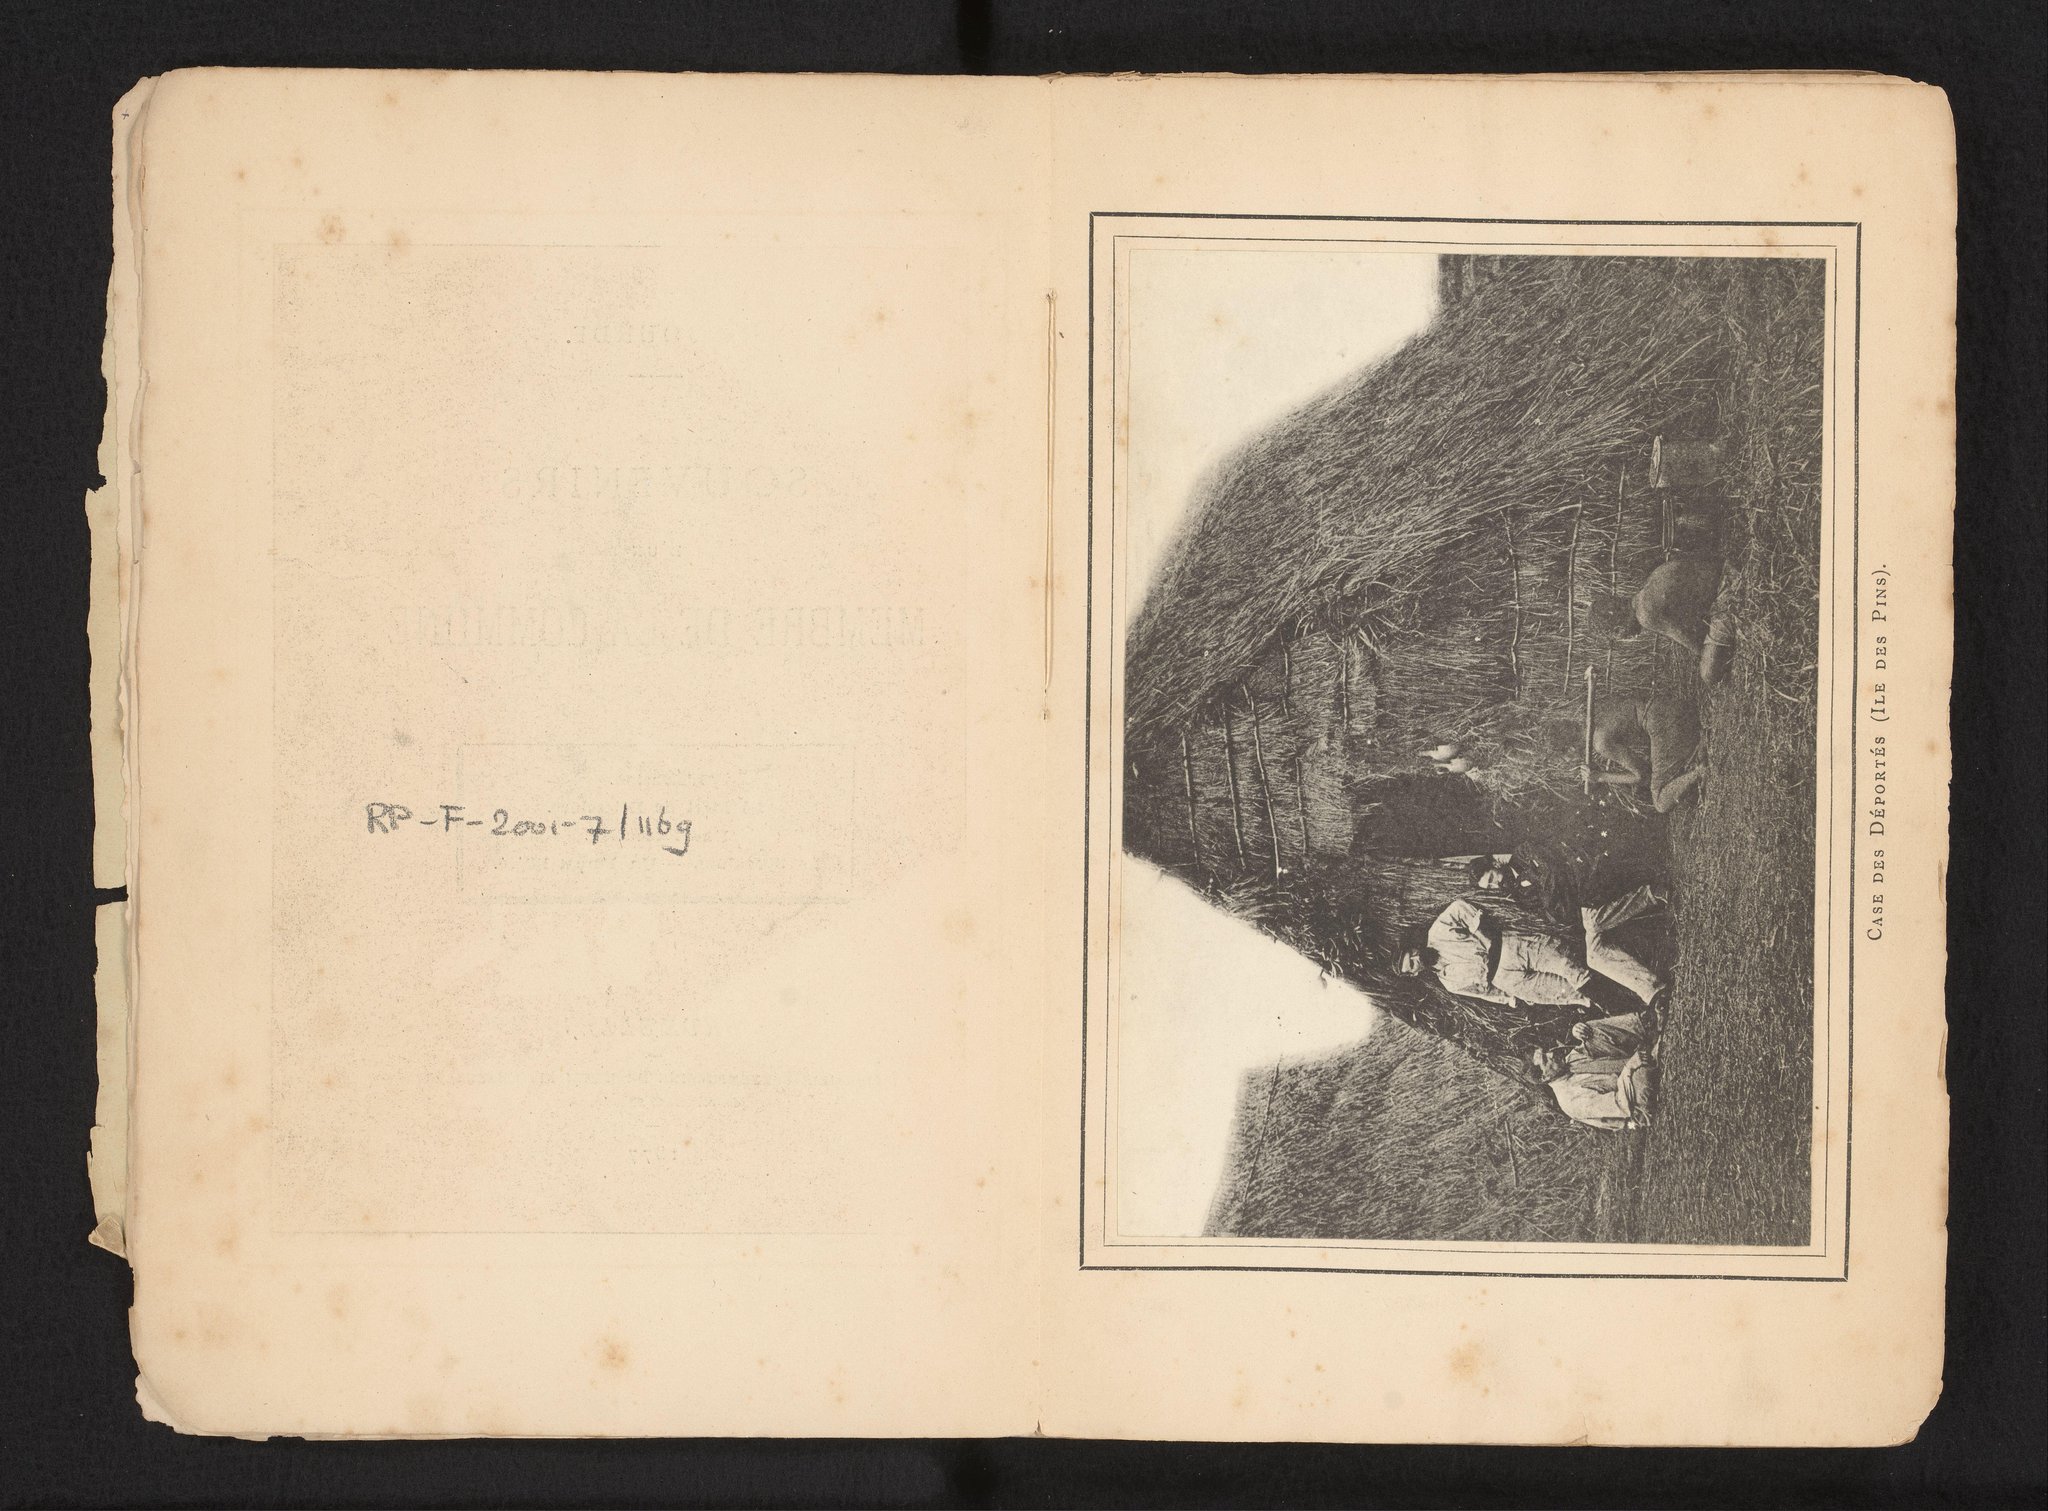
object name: page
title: Gezicht op vijf onbekende mannen voor een strooien woning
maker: Anonymous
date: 1872-1877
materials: paper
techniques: photograph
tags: historical persons, housing